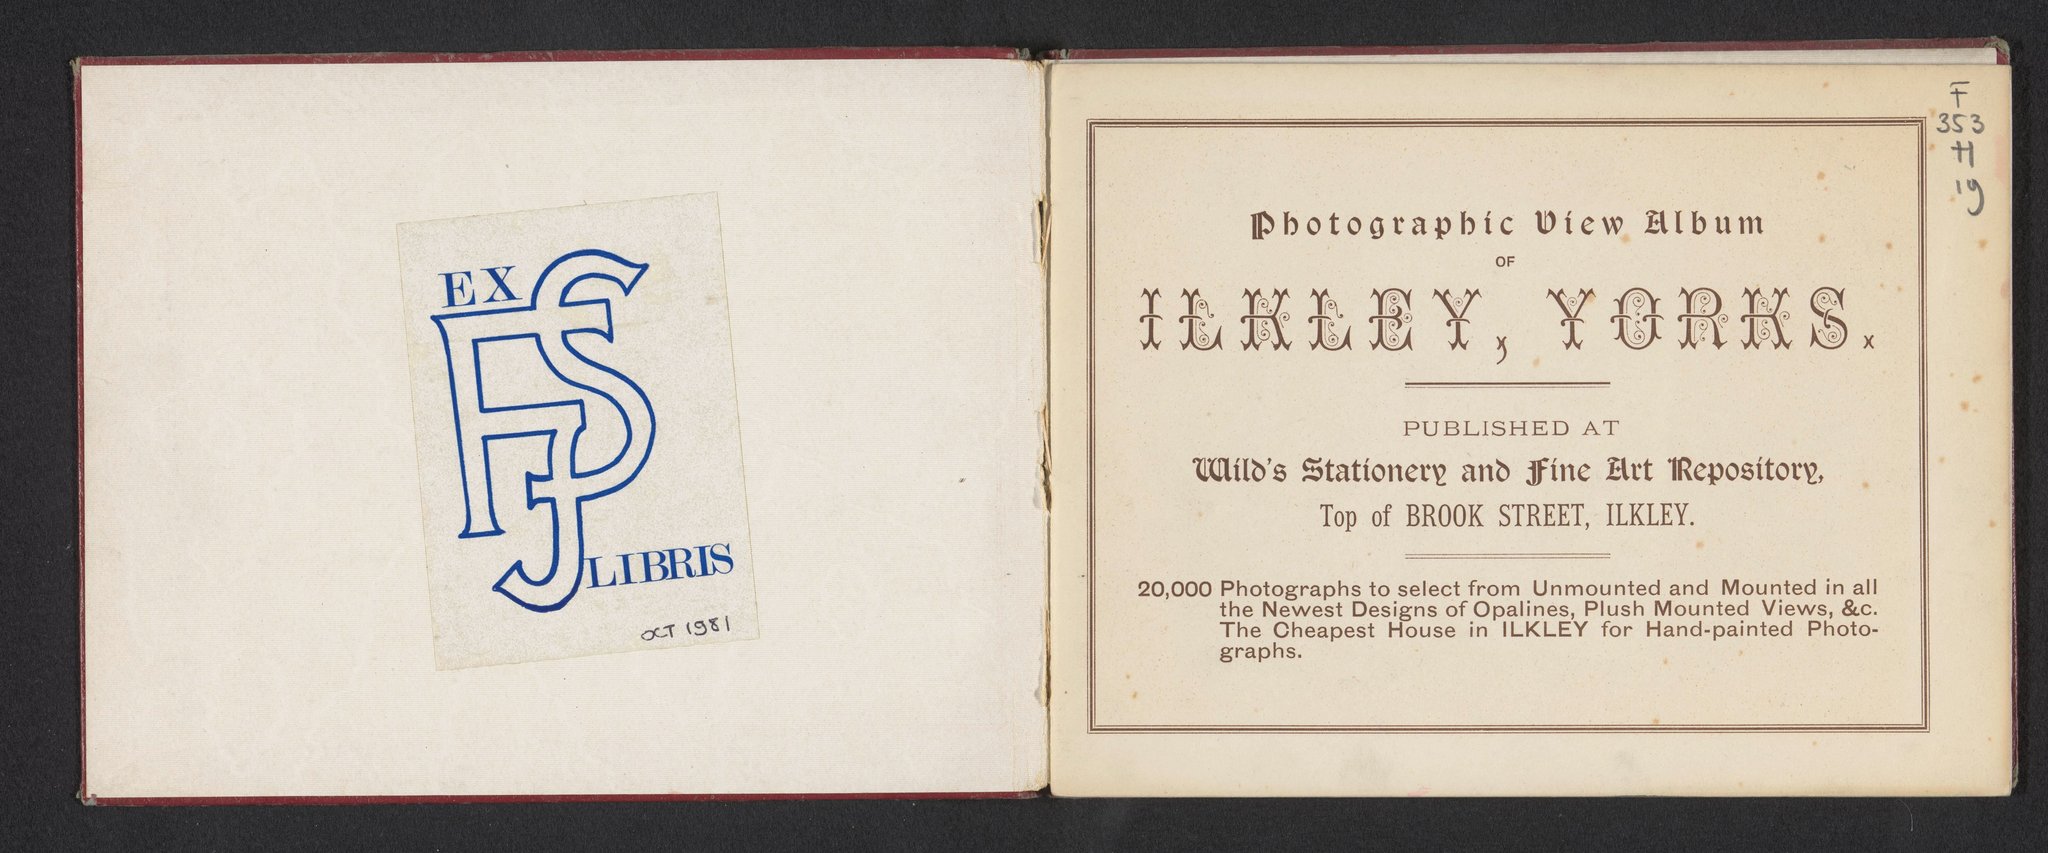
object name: book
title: Photographic view album of Ilkley, Yorks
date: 1900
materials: cardboard, linen, paper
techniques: photograph, printing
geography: ilkley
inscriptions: inscription: ‘ex libris SFJ’